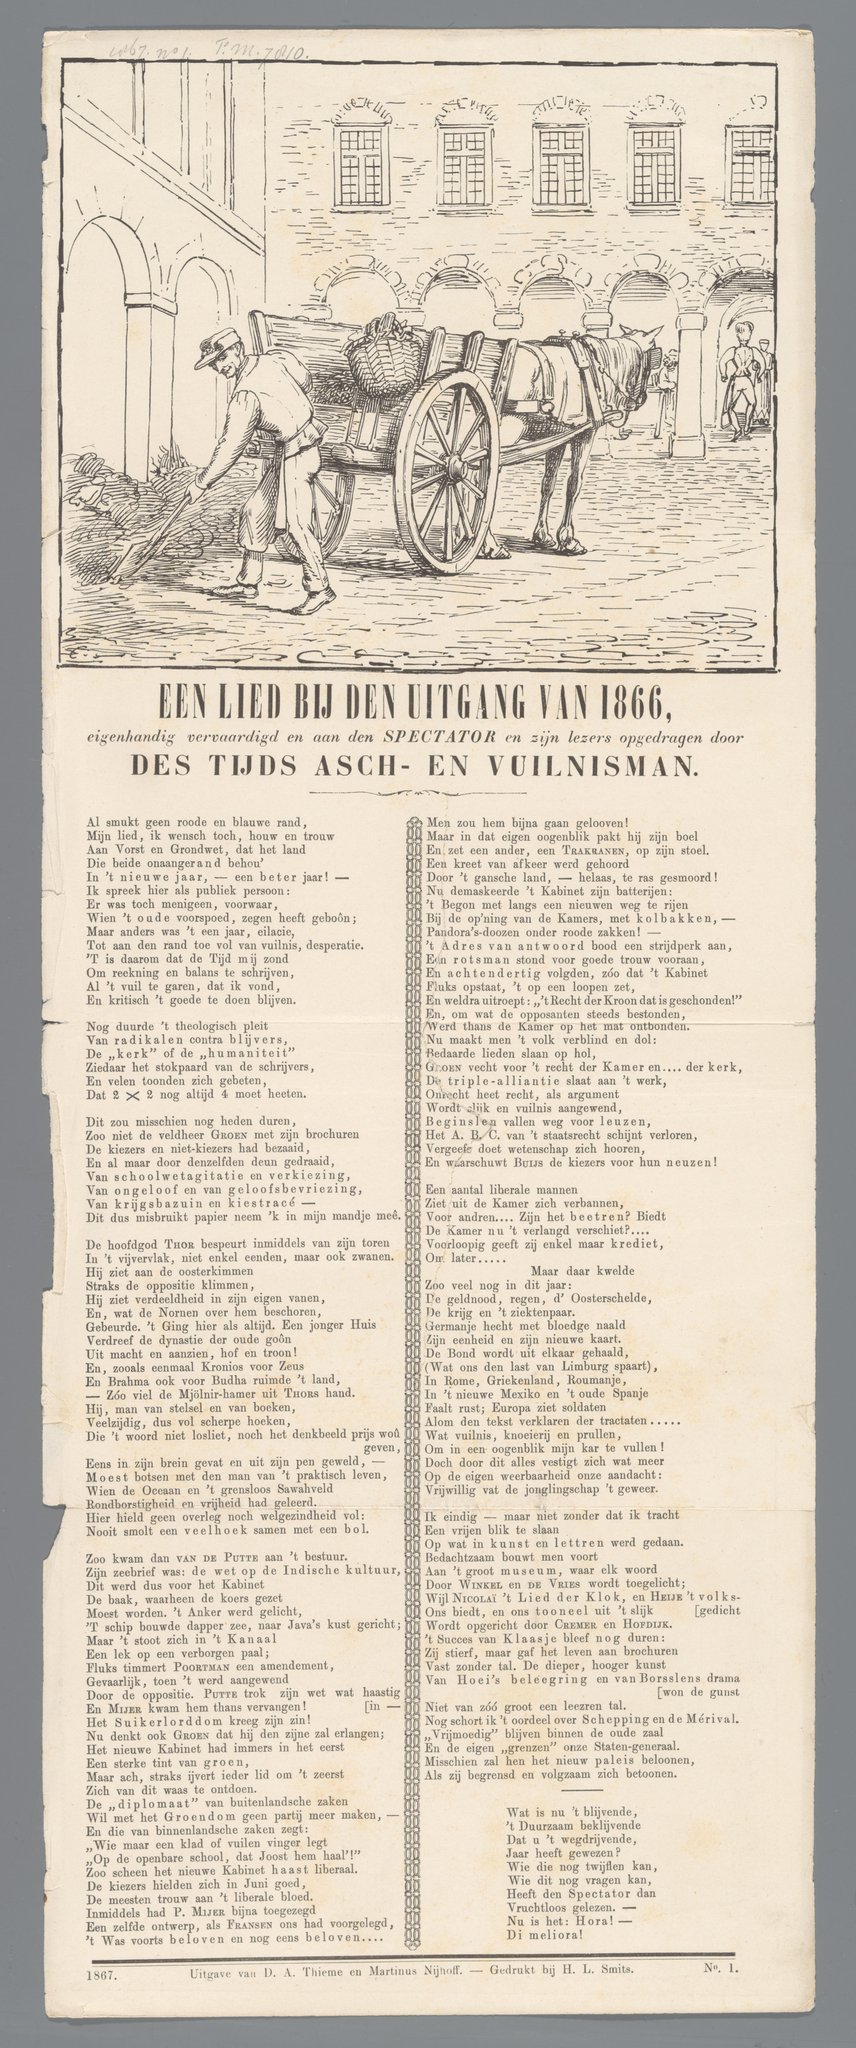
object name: cartoon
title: Een lied bij den uitgang van 1866, eigenhandig vervaardigd en aan den Spectator en zijn lezers opgedragen door des Tijds Asch- en Vuilnisman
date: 1867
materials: paper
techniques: lithograph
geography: netherlands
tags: garbage collection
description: Spotprent in de vorm van een nieuwjaarswens voor het jaar 1867 door de as- en vuilnisman. Een vuilnisman met kar ruimt op het Binnenhof het vuil van het afgelopen jaar 1866 op. Onder de afbeelding een vers in twee kolommen. Plaat verschenen bij het weekblad De Nederlandsche Spectator, nr. 1, 5 januari 1867.